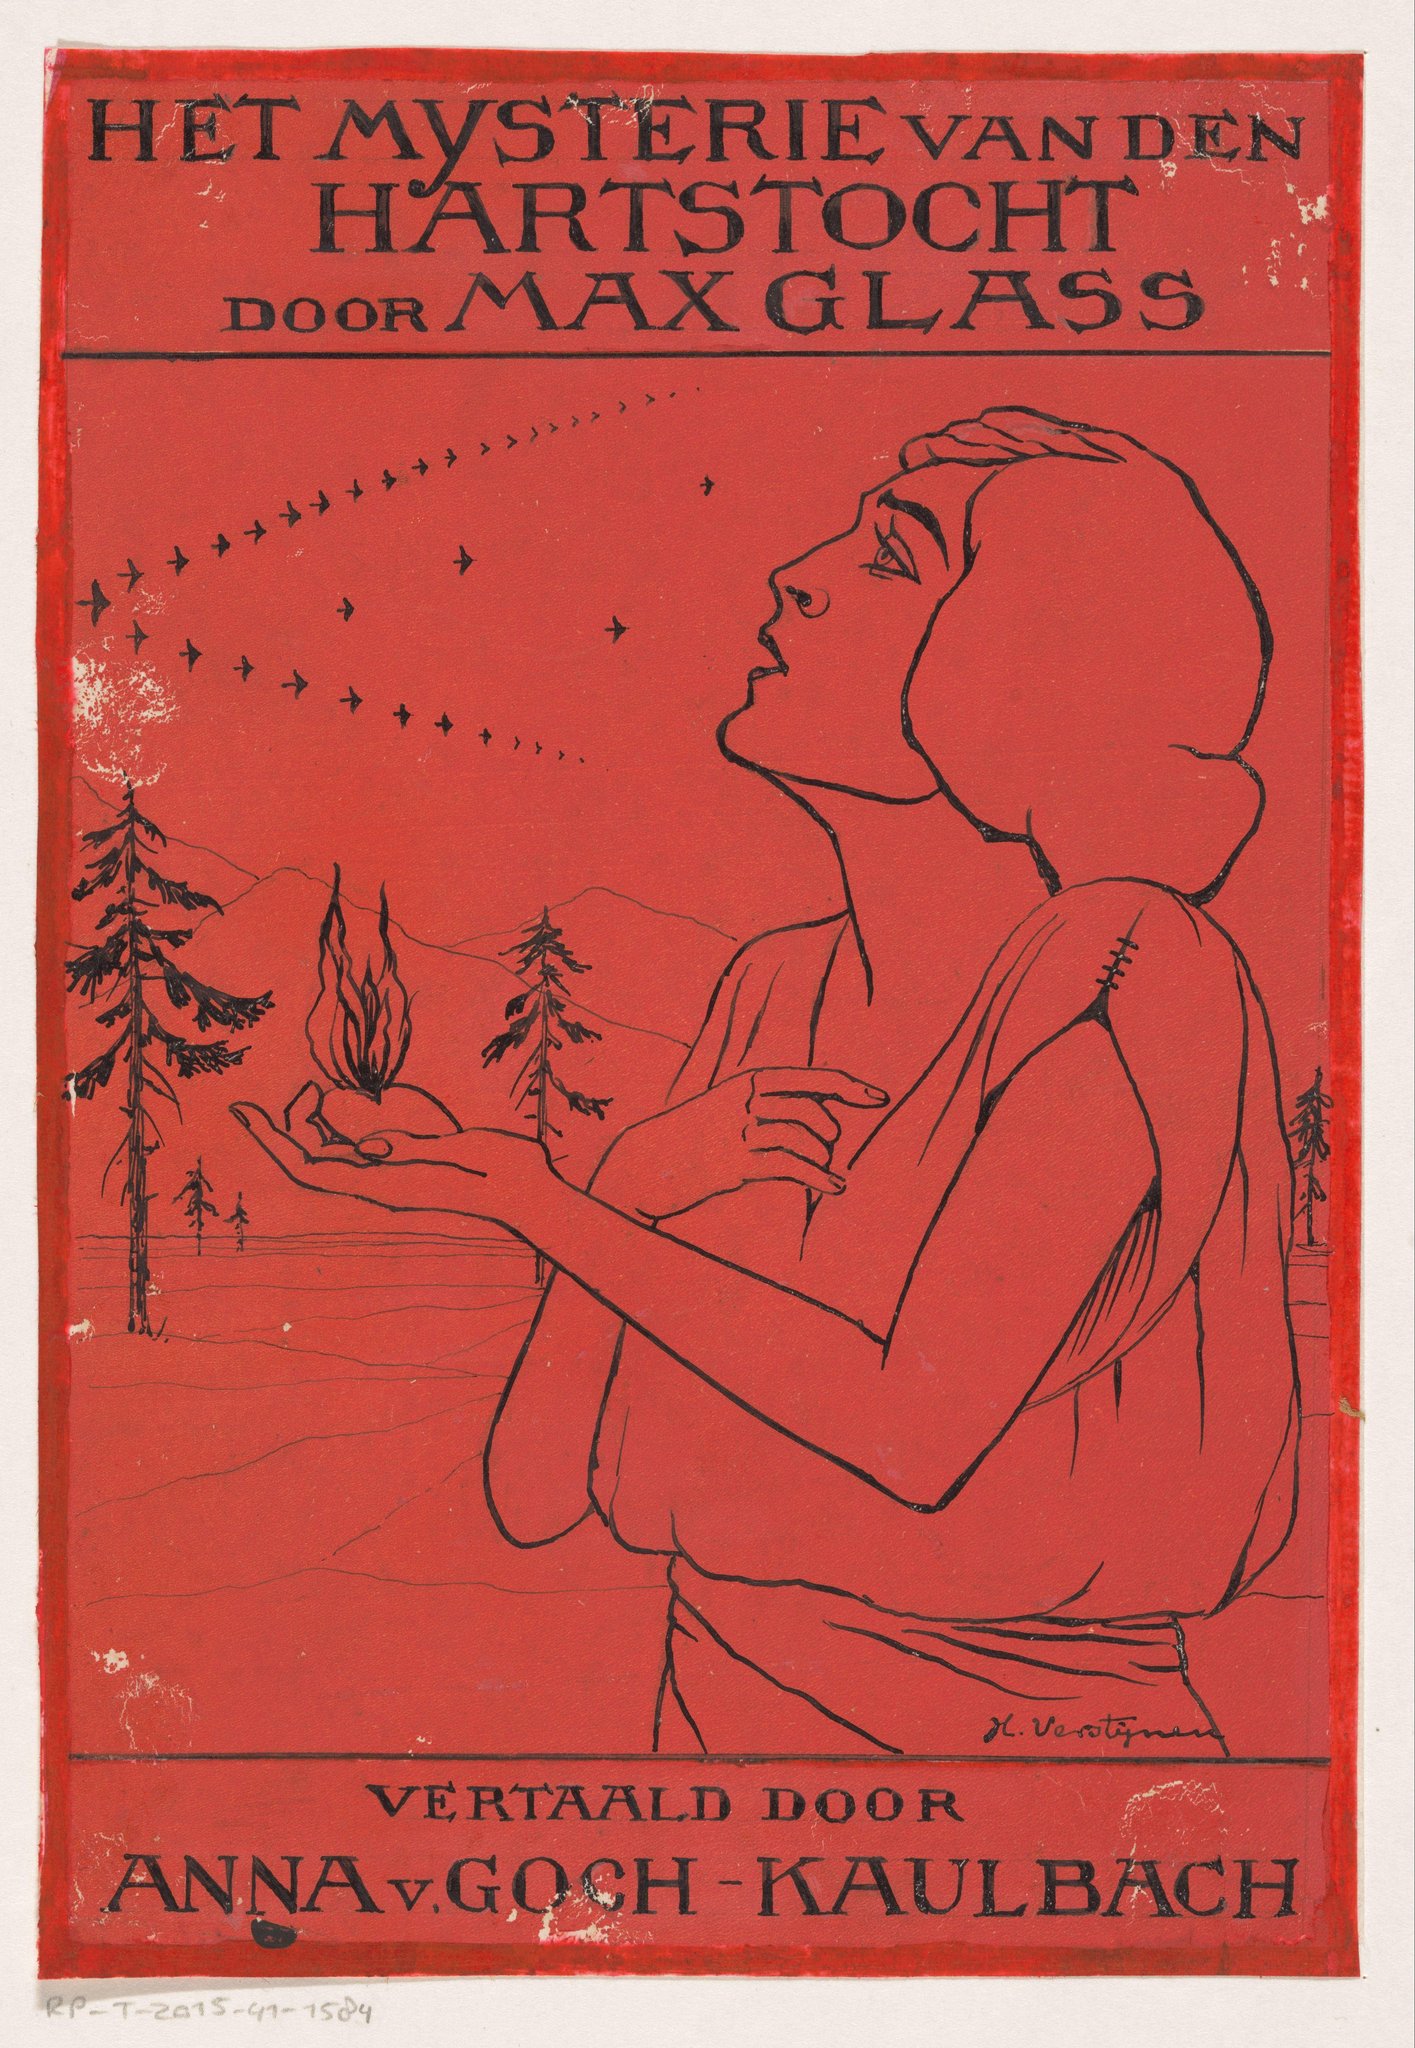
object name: study for binding design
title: Bandontwerp voor: Max Glass, Het mysterie van den hartstocht (Das mysterium der Leidenschaft), 1923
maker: henri verstijnen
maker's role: draughtsman, print maker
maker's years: 1882-1940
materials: ink, paper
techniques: pen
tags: arm stretched forward, flame, mountains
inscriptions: collector's mark: Lugt 2228a, signature: ‘H. Verstijnen’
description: Een jonge vrouw in een tuniek met korte mouwen staat in een berglandschap met bomen. De vrouw houdt haar rechterhand tegen haar borst en kijkt omhoog. In haar uitgestoken linkerhand steken vlammen op uit een steen. In de lucht vliegt een zwerm vogels.